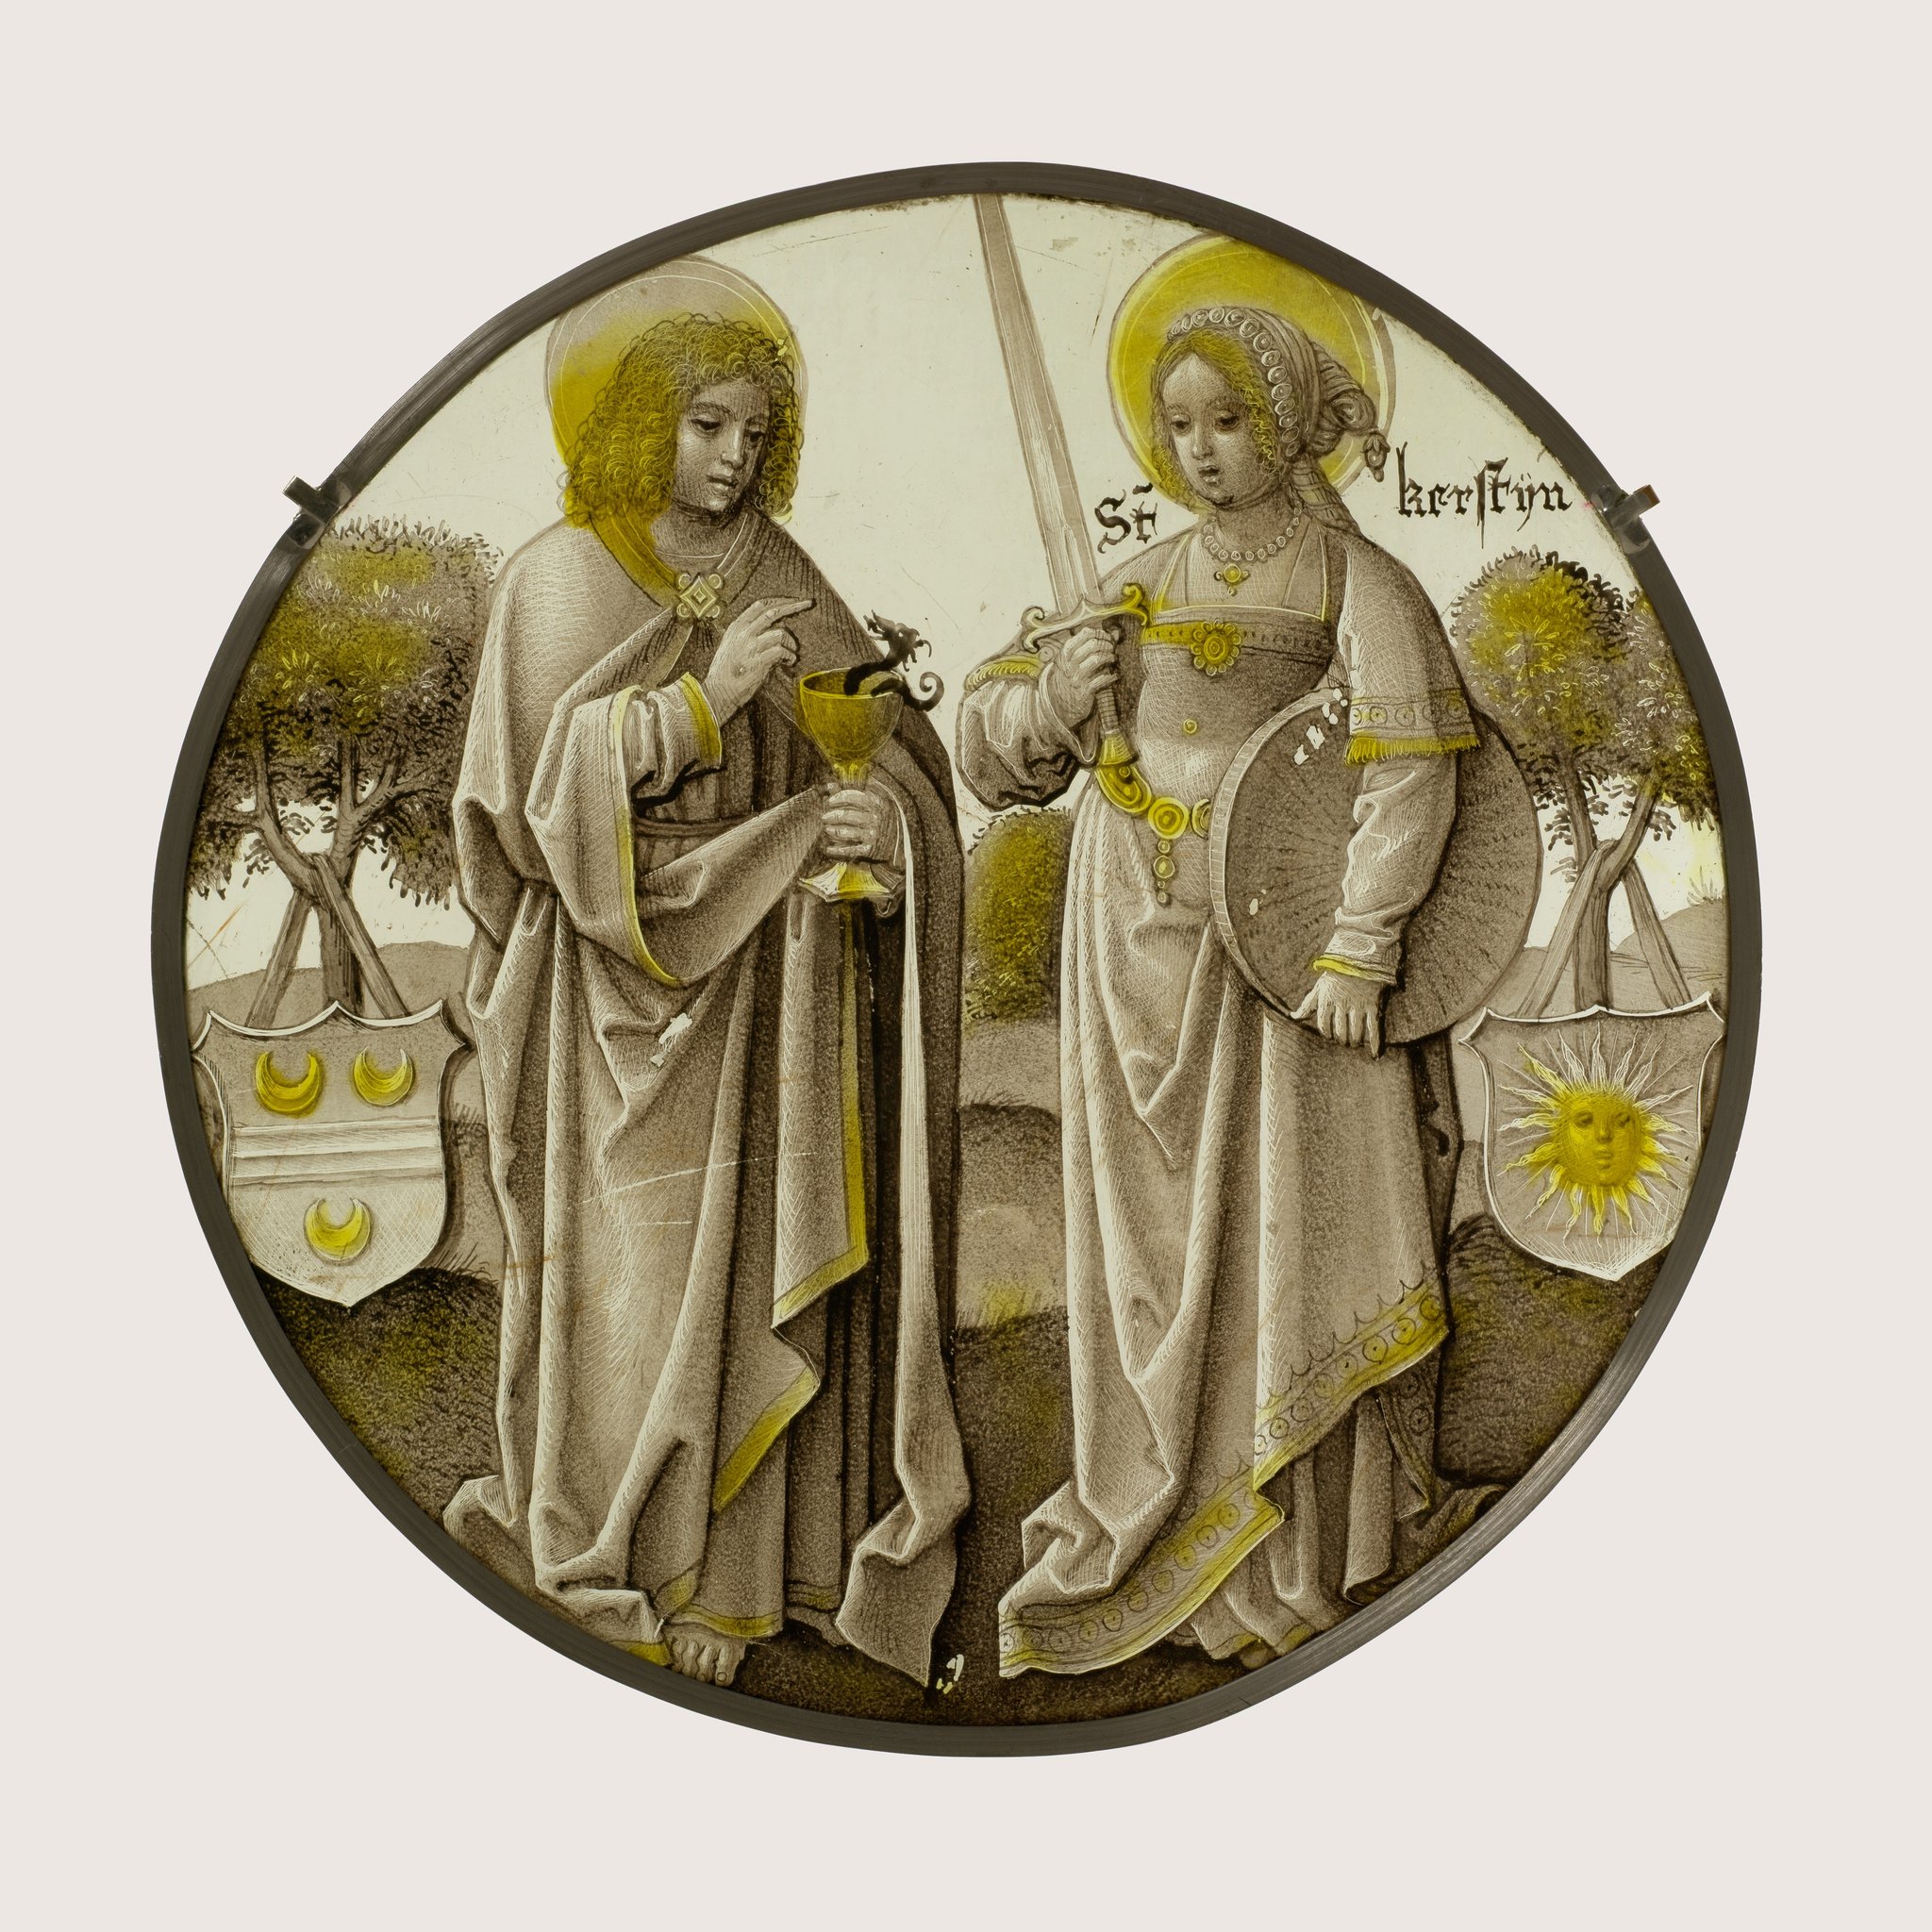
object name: roundel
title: Heraldic Roundel with Saints John the Evangelist and Christina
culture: south netherlandish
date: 1500-1510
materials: glass, paint, pigment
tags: swords,men,women,saint john the evangelist,saints,coat of arms